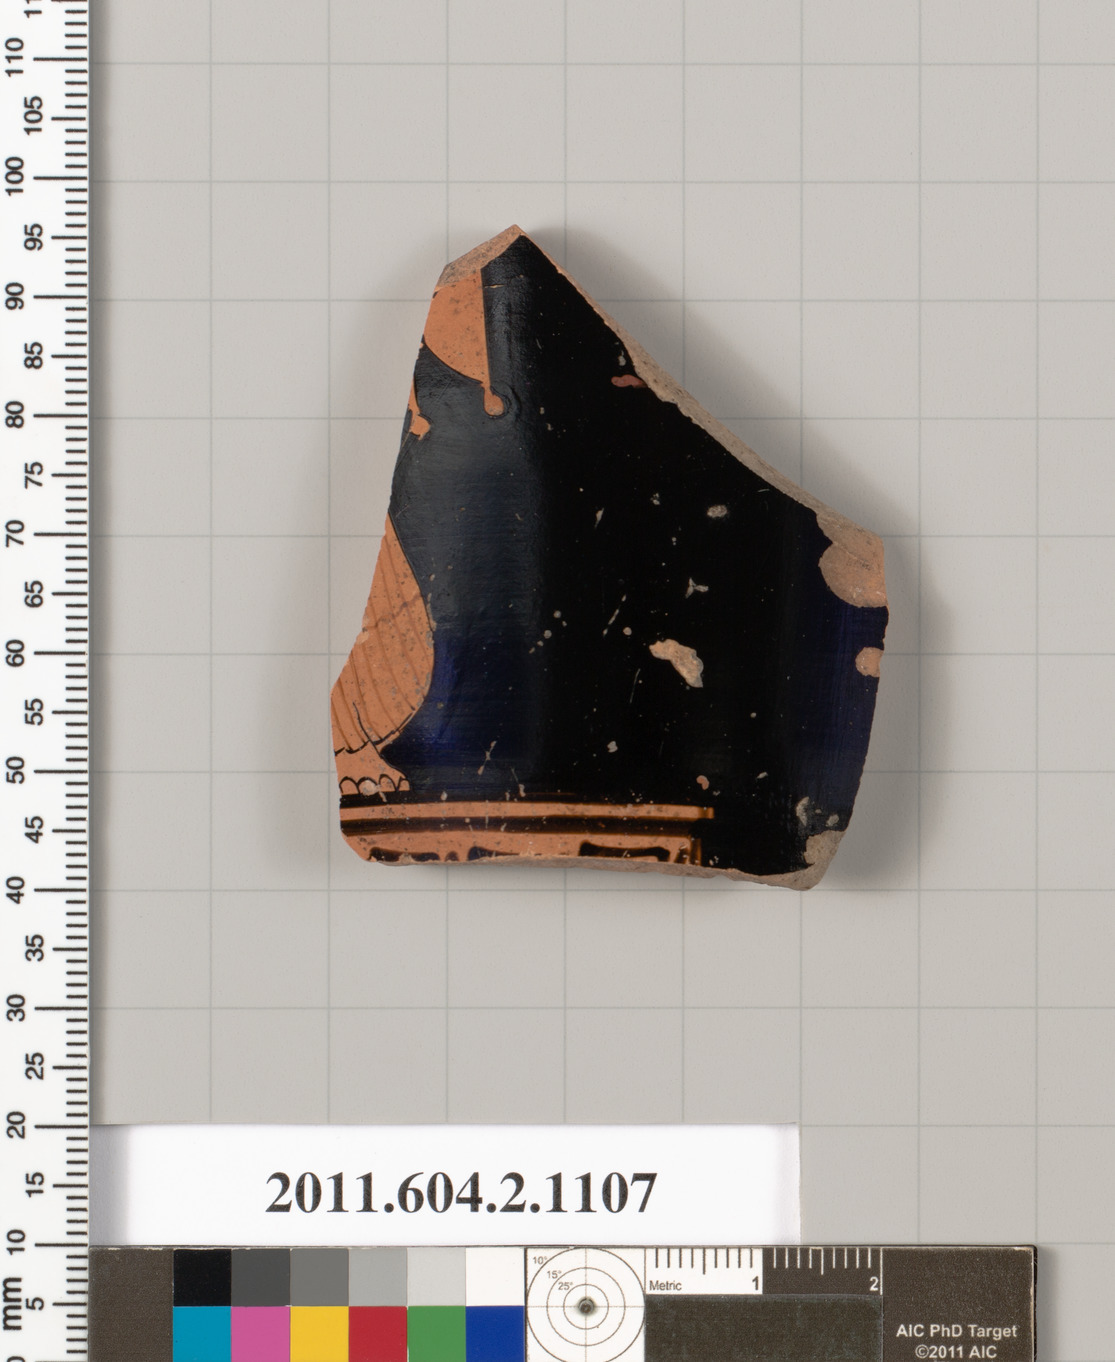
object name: lekythos fragment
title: Terracotta fragment of a lekythos (oil flask)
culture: greek, attic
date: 475-451 BCE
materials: terracotta